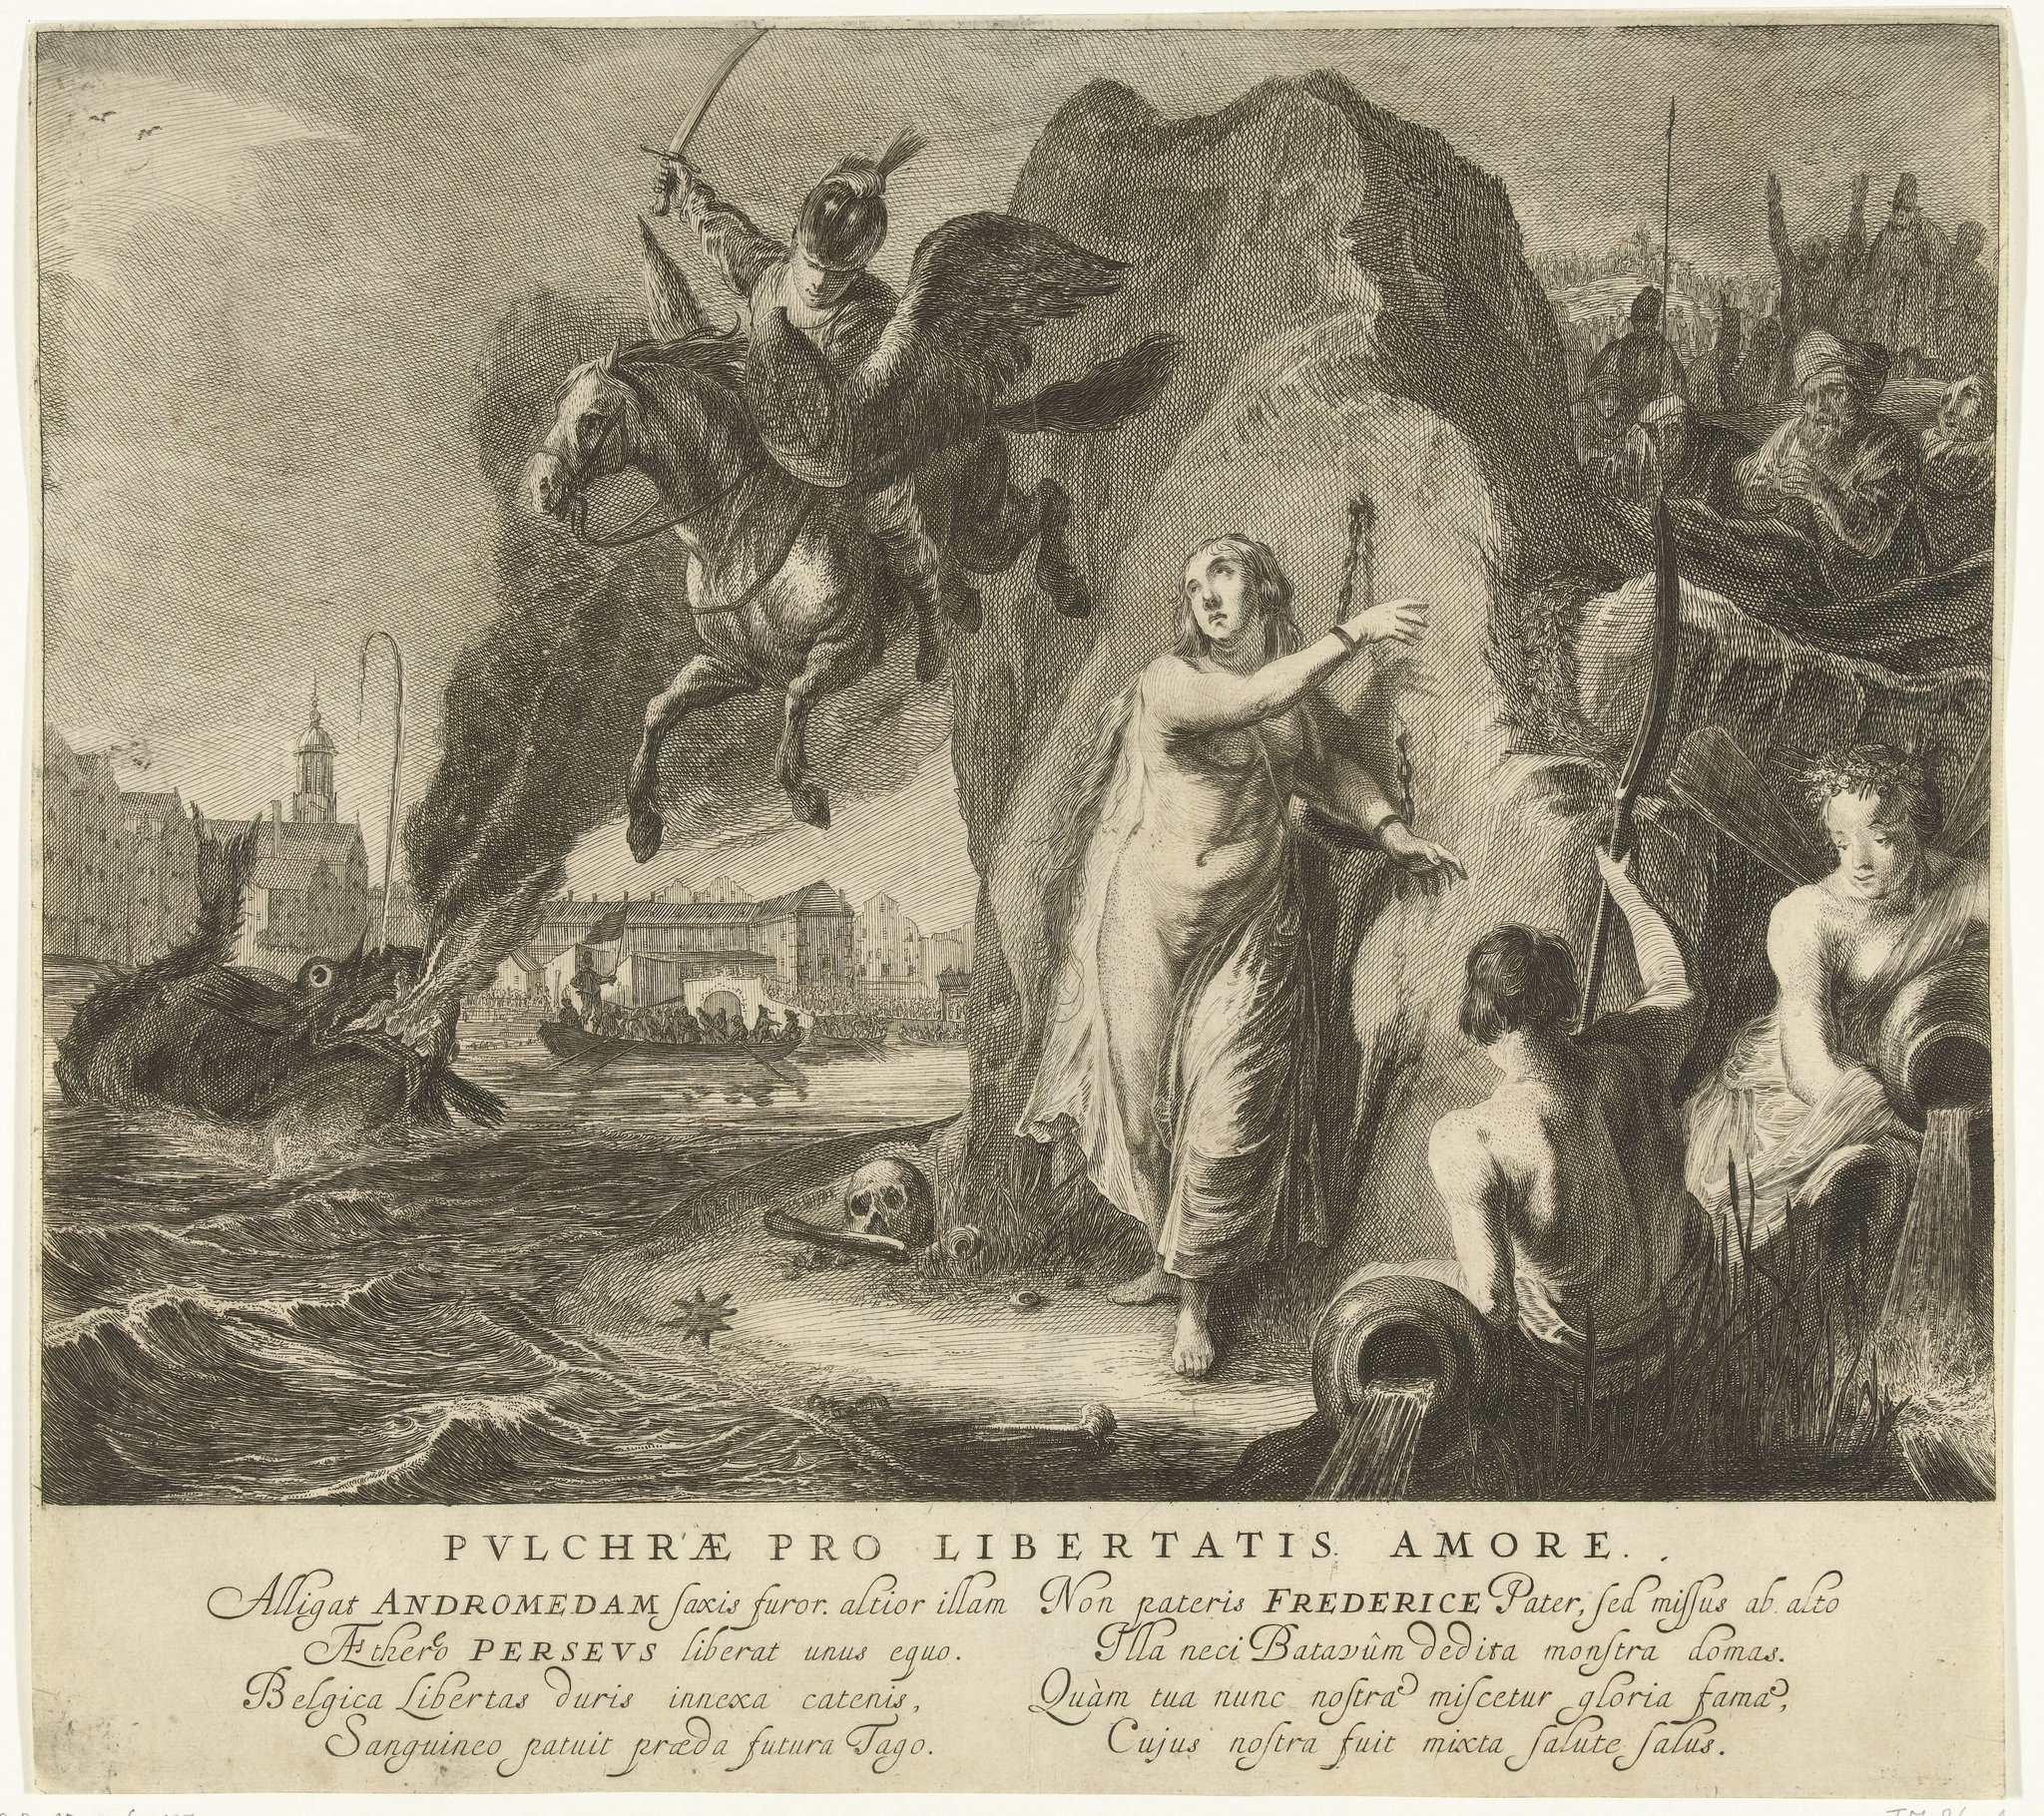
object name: print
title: Pulchrae pro libertatis amore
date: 1642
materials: paper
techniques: etching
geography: northern netherlands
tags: henriëtta maria van frankrijk (koningin van engeland, schotland en ierland), 'tableau vivant', perseus kills the sea monster (or turns it into stone by showing it the gorgon's head) to release andromeda; sometimes her parents cepheus and cassiopea watch the scene, triumphal entry and public reception, pageant, 'entrée solennelle', 'joyeuse entrée', amsterdam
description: Allegorisch tableau vivant met stadhouder Frederik Hendrik die als Perseus tot de redding van Andromeda (Nederland) komt. Links in het water het zeemonster (Spanje). Vertoning gepland - maar uiteindelijk niet uitgevoerd - op het water van het Damrak bij het bezoek van Engelse koningin Henrietta Maria aan Amsterdam, 20-22 mei 1642. In het onderschrift de titel en 2 keer 4 regels in het Latijn. Tweede plaat in een groep van tien vertoningen en triomfbogen.